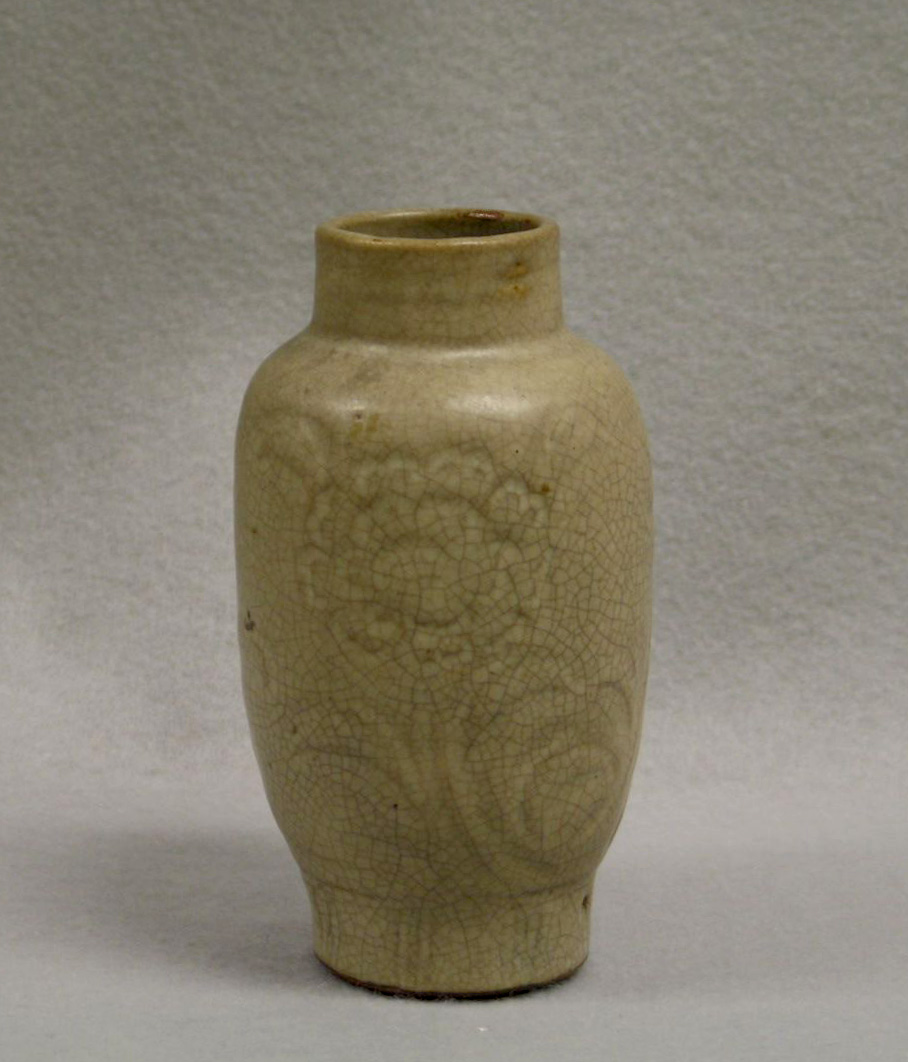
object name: jar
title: Jar with flowers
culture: chinese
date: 1501-1600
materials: ceramic glaze, glaze, stoneware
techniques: incising